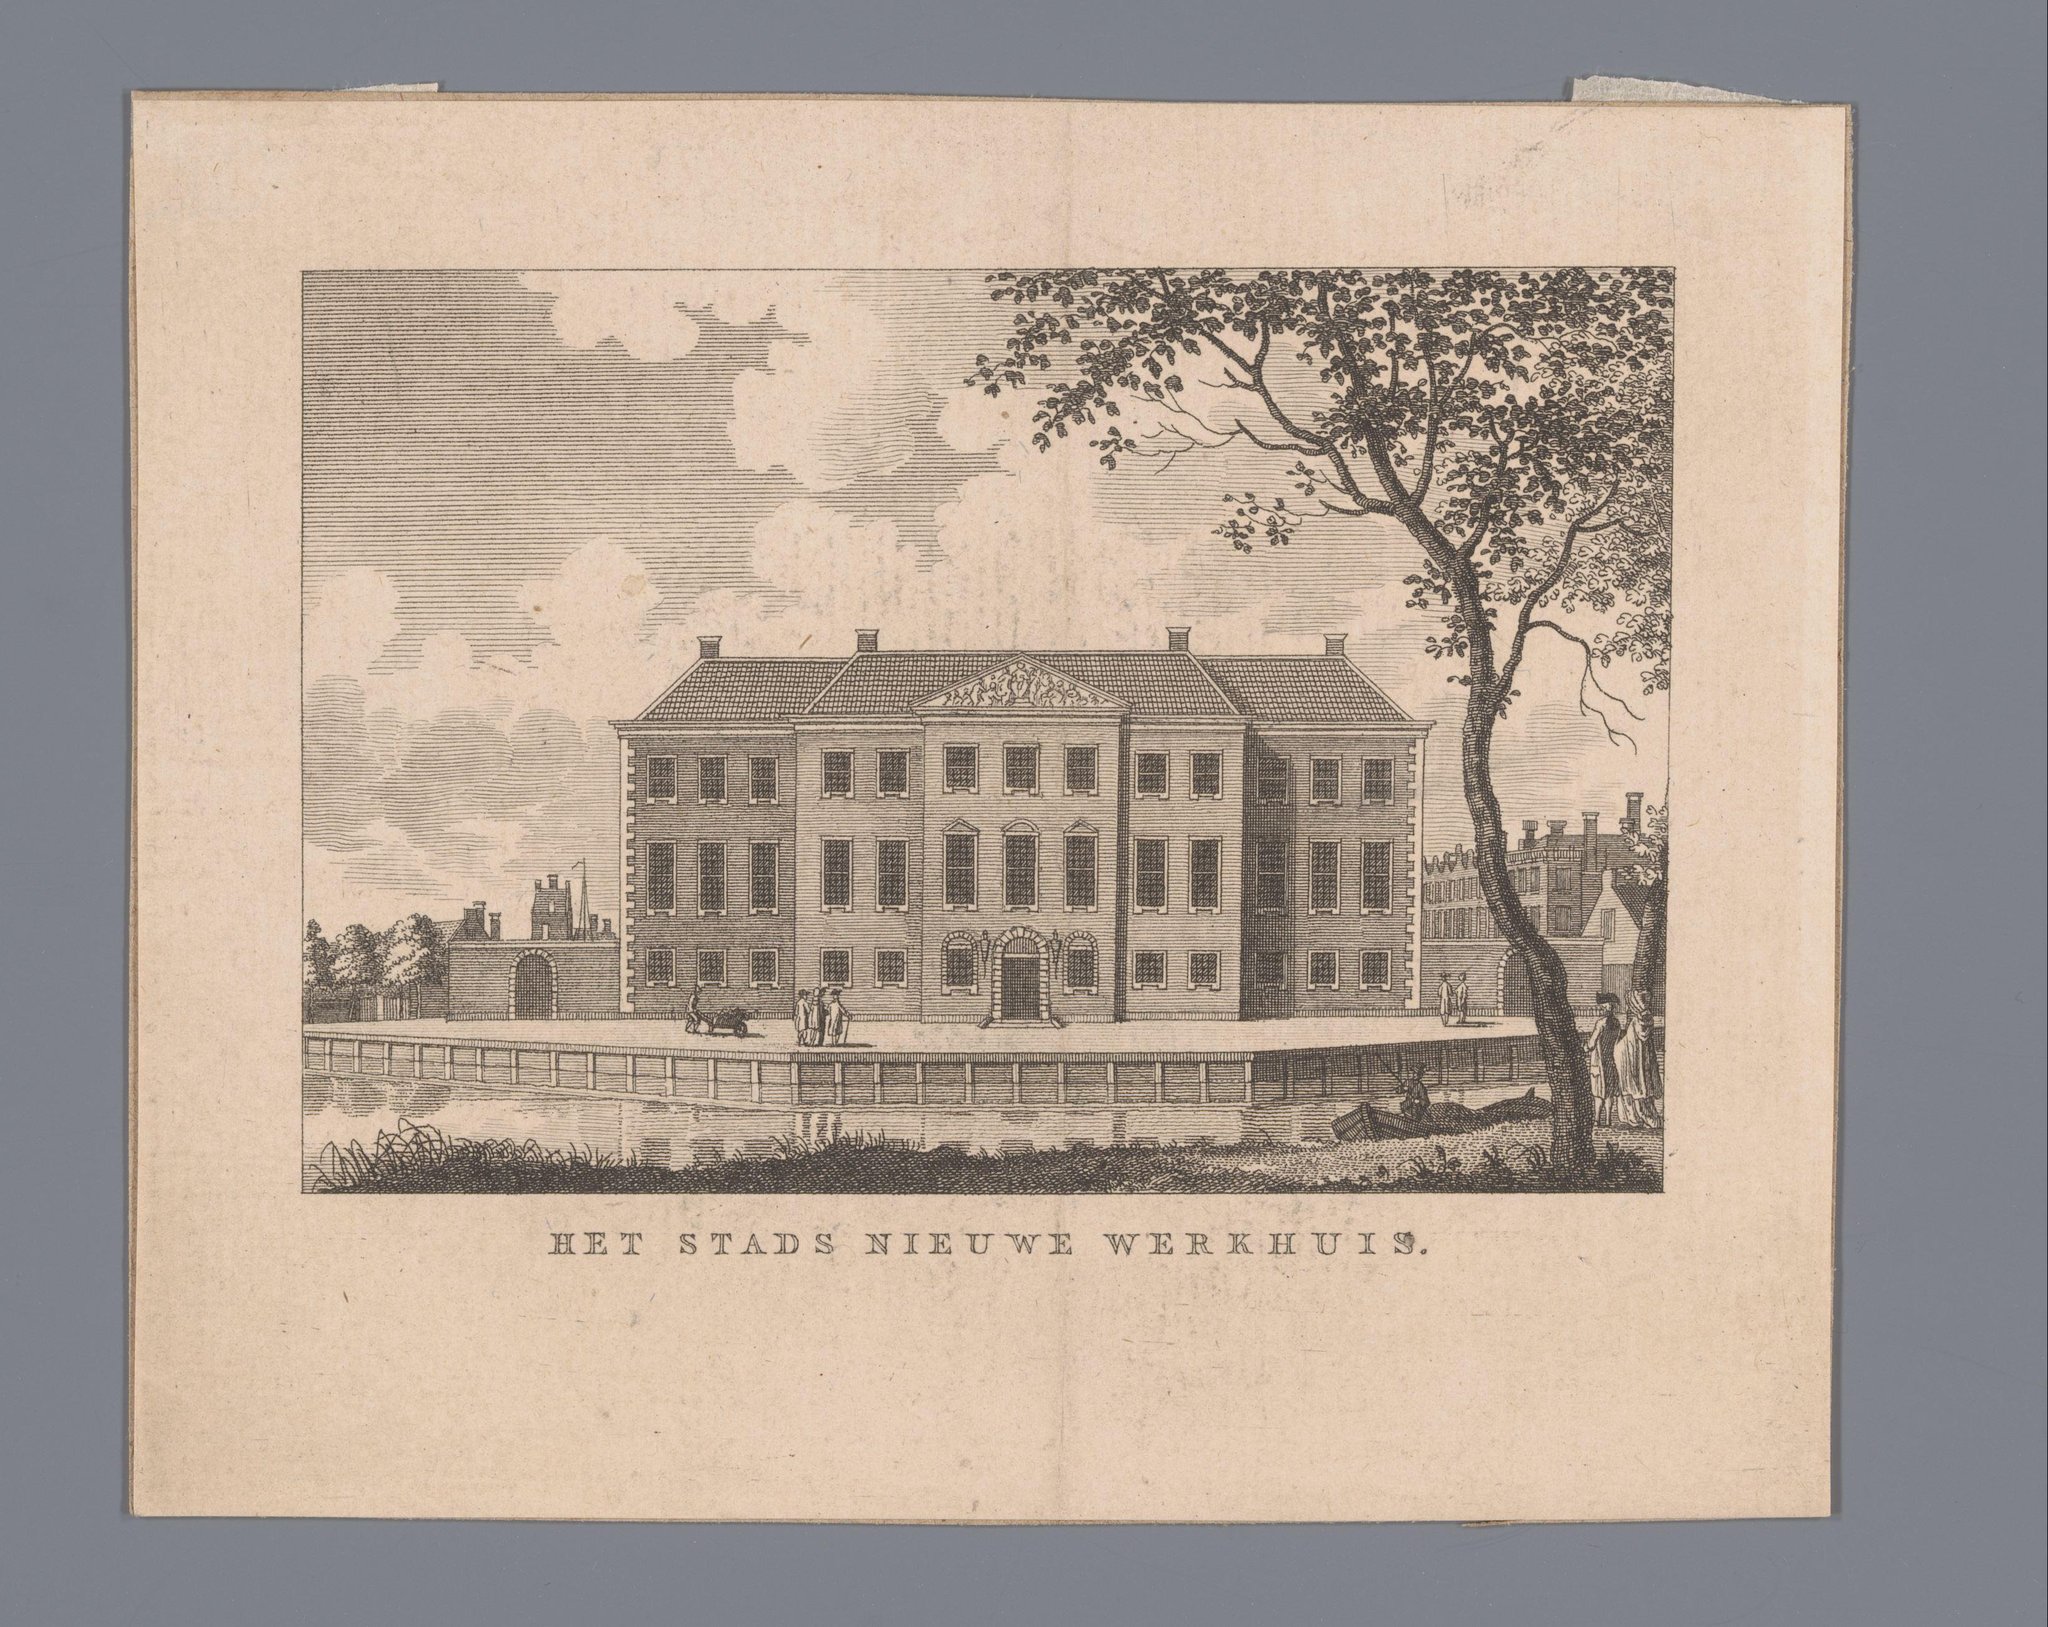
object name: print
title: Gezicht op het Nieuwe Werkhuis te Amsterdam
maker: Anonymous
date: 1790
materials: paper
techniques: engraving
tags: civic architecture; edifices; dwellings